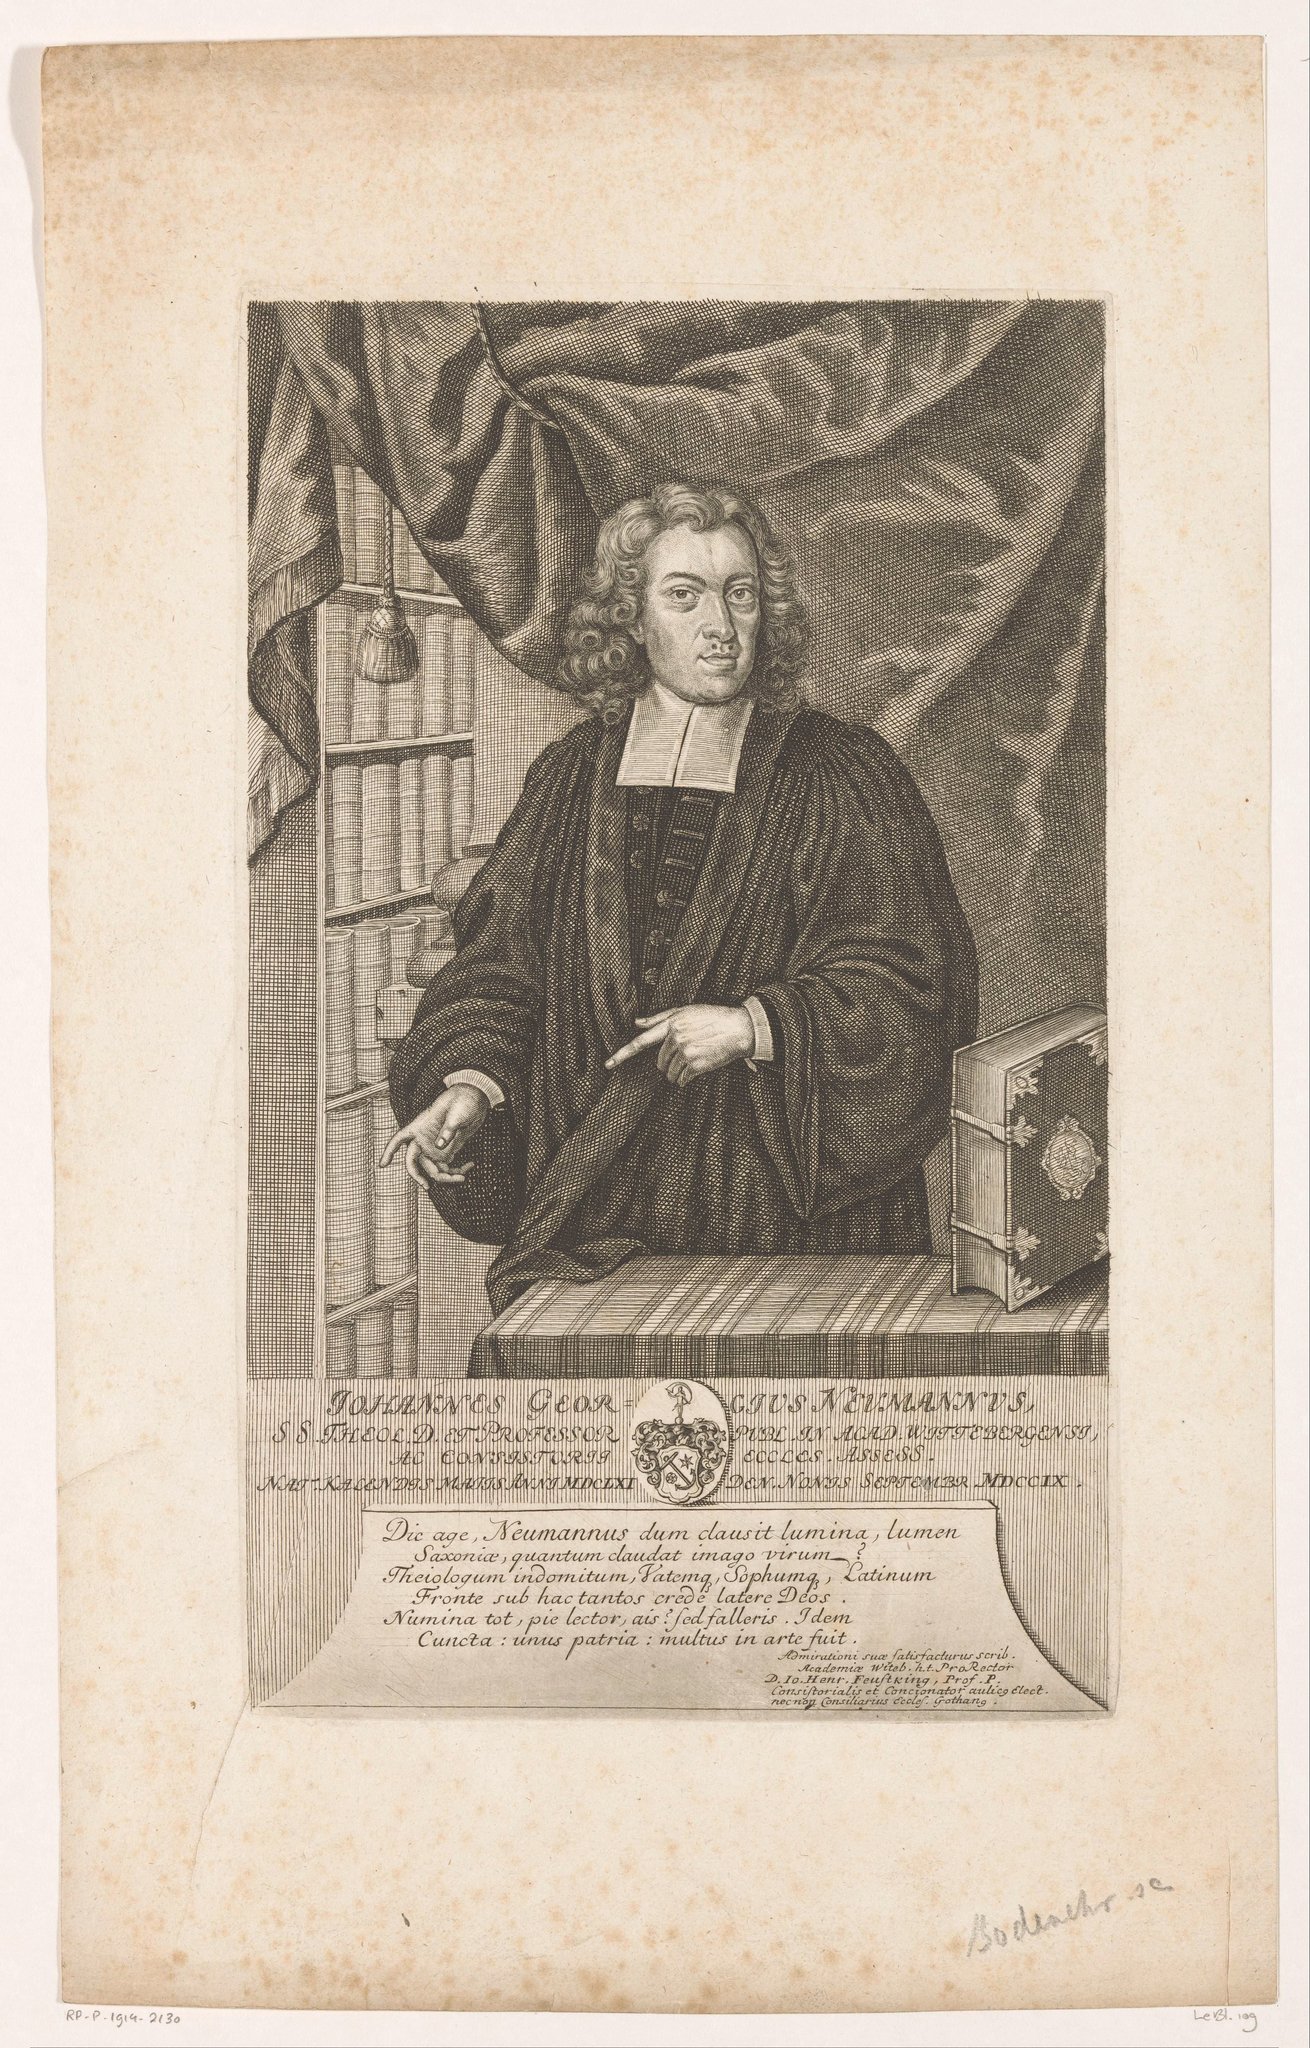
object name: print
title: Portret van Johann Georg Neumann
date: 1709-1748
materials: paper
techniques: engraving, intaglio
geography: wittenberg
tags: bookshelves, historical persons, book, armorial bearing, heraldry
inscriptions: collector's mark: Lugt 2228